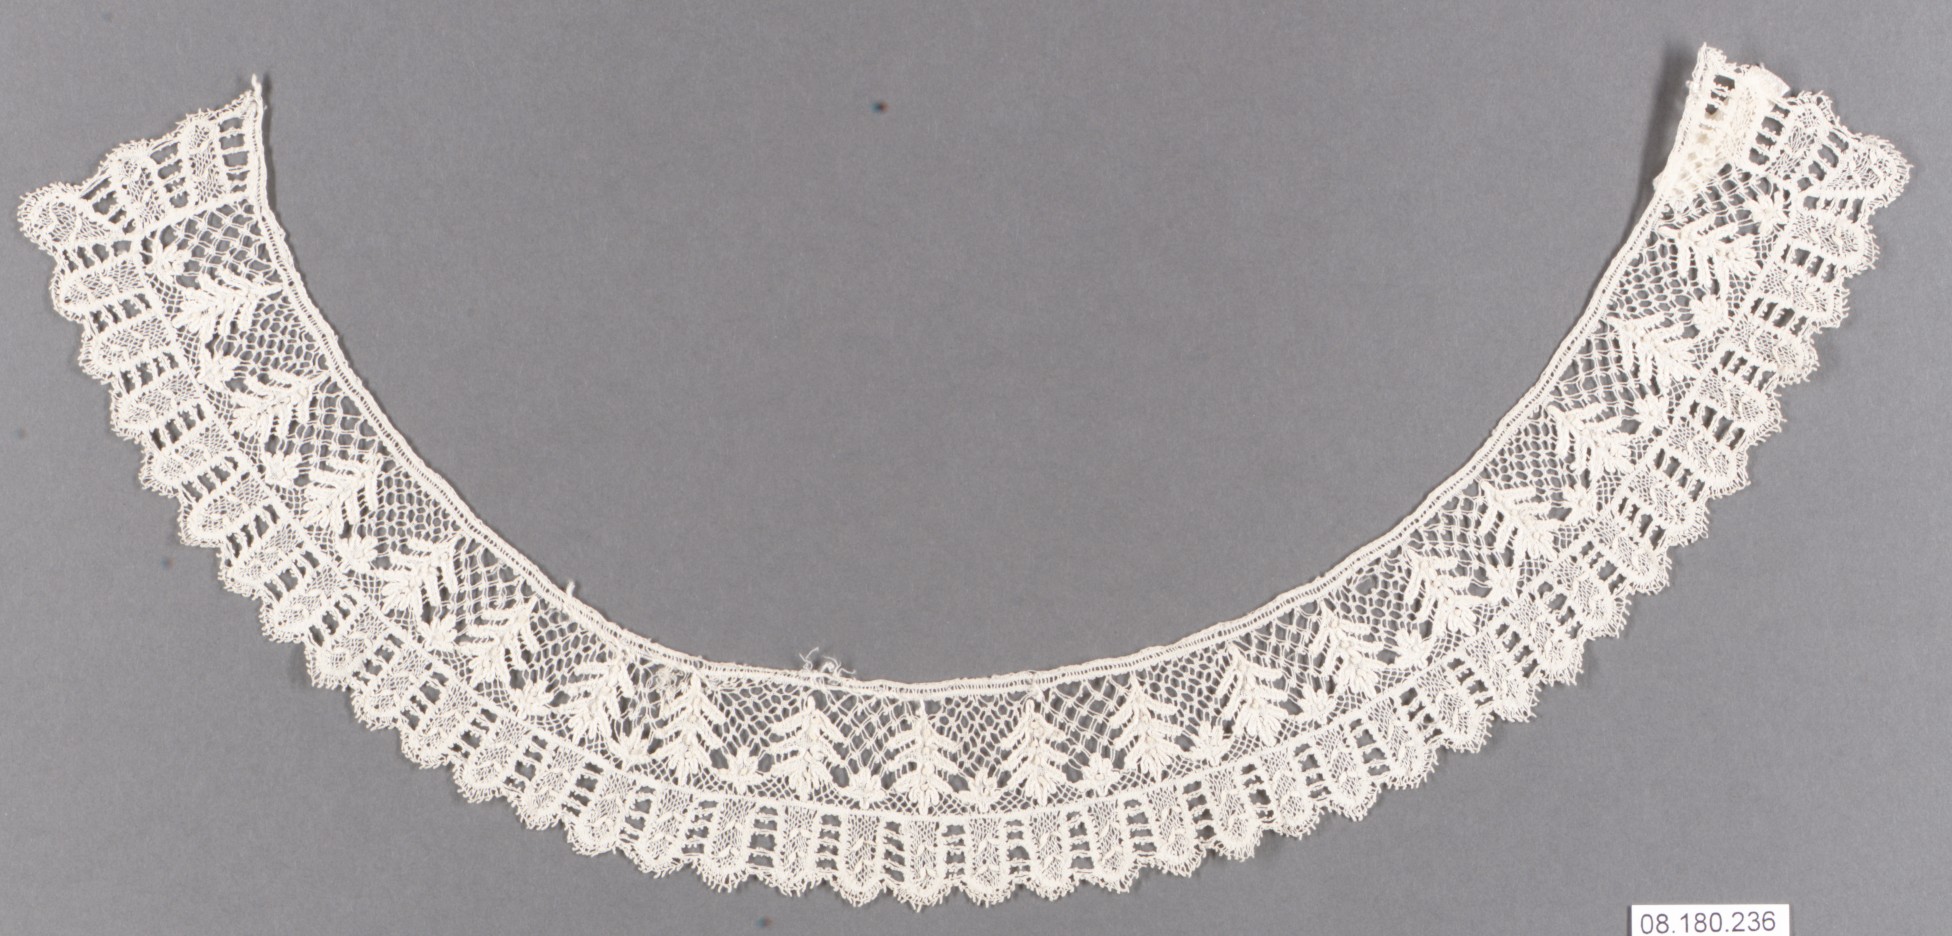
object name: collar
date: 1801-1900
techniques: lace